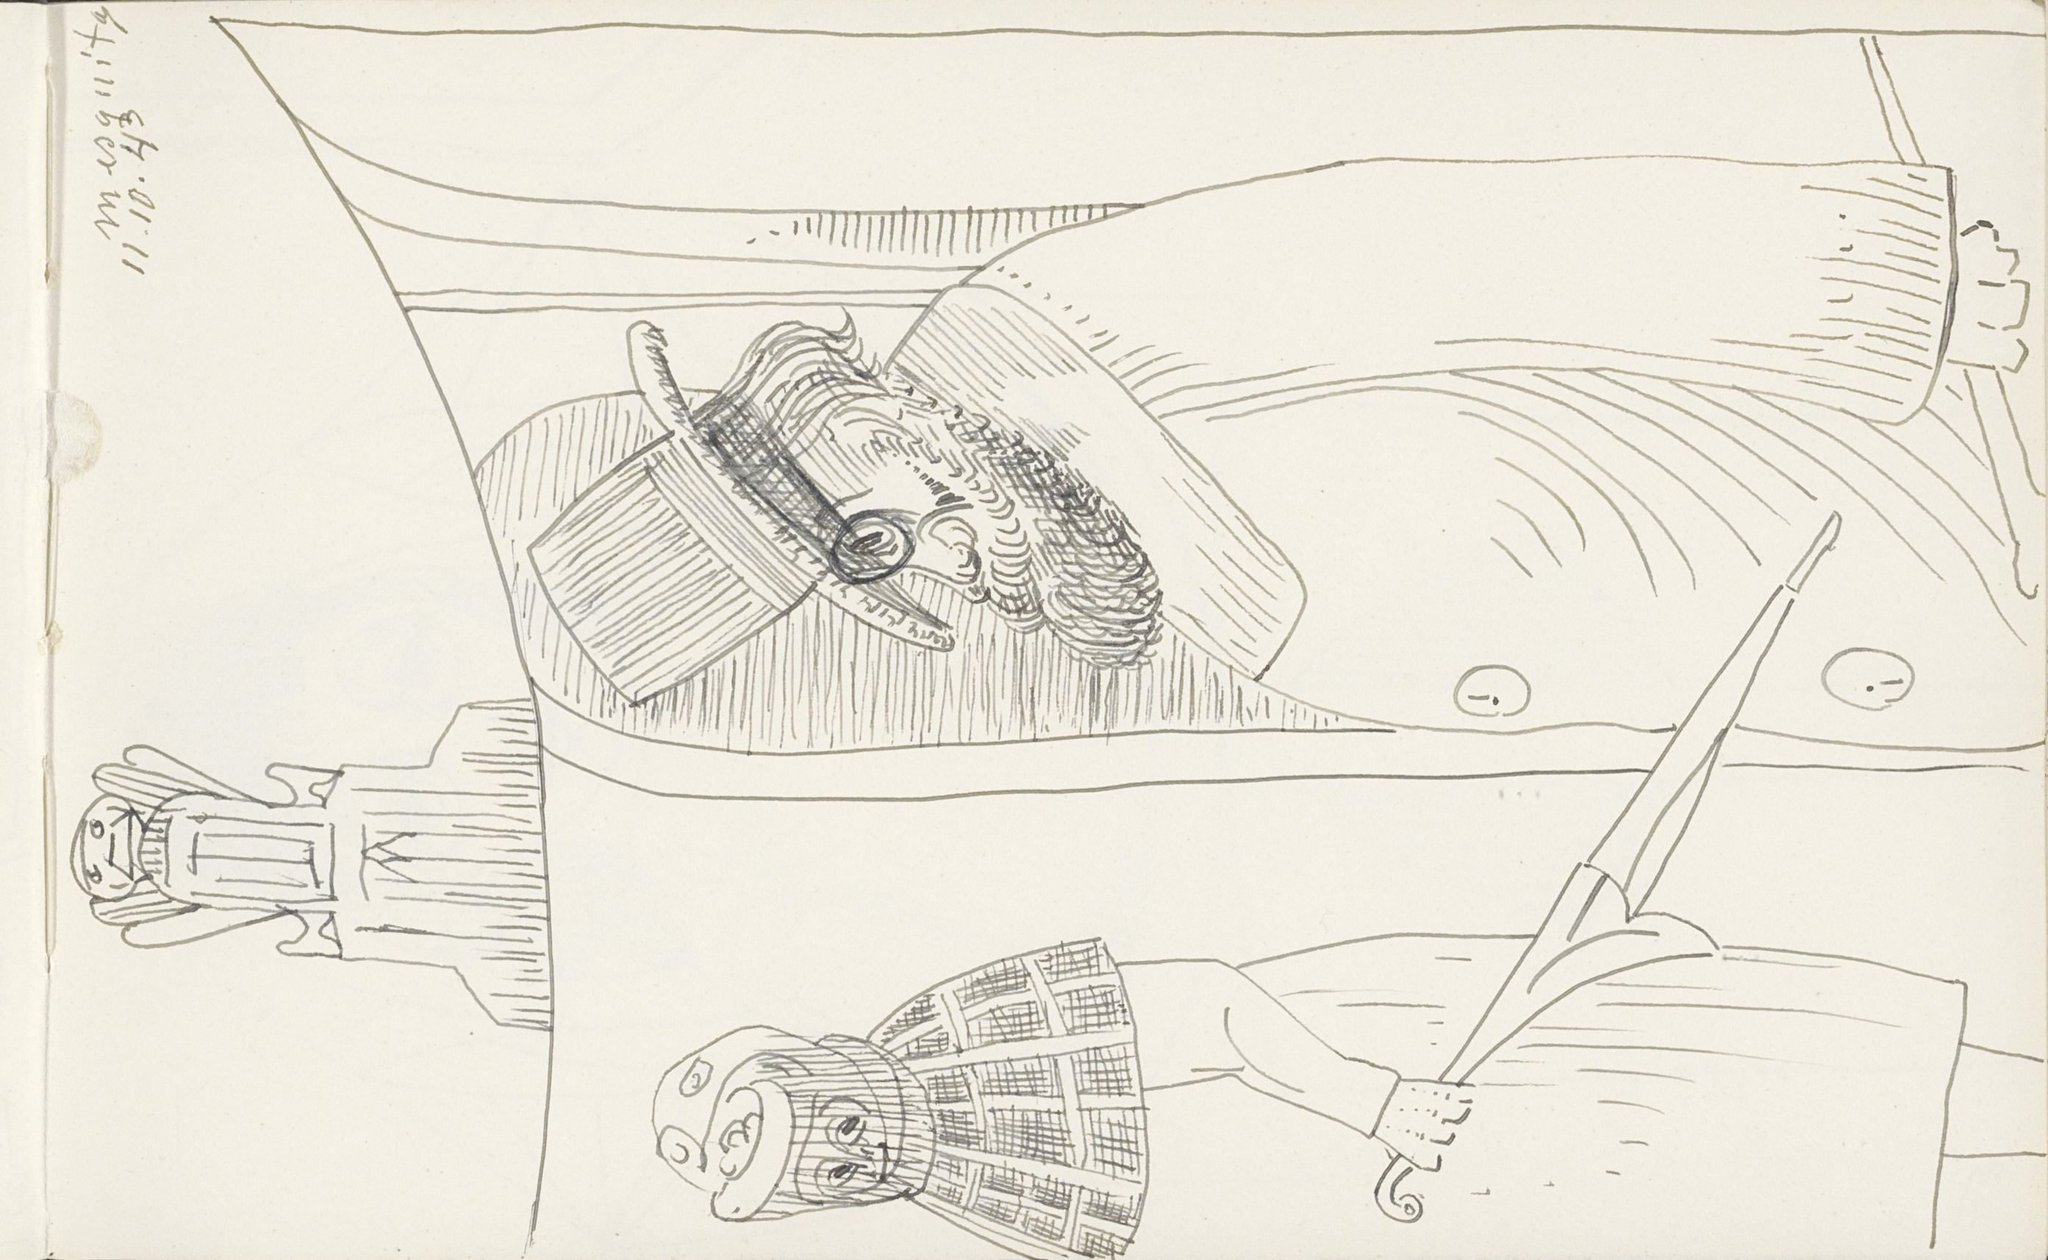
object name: sketchbook leaf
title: Vrouw met een paraplu en een man met een hoge hoed, baard en wandelstok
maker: samuel jessurun de mesquita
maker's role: draughtsman, print maker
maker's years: 1868-1944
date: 1943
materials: ink, paper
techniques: pen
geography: amsterdam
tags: adult woman, walking-stick, staff, adult man, umbrella, surrealia, surrealistic representations, beard, head-gear: top hat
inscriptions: signature and date: ‘mesquita/ 11.10.43’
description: Op de achtergrond een fantasiefiguur met ogen en poten. Blad 3 recto uit een schetsboek met 18 bladen.